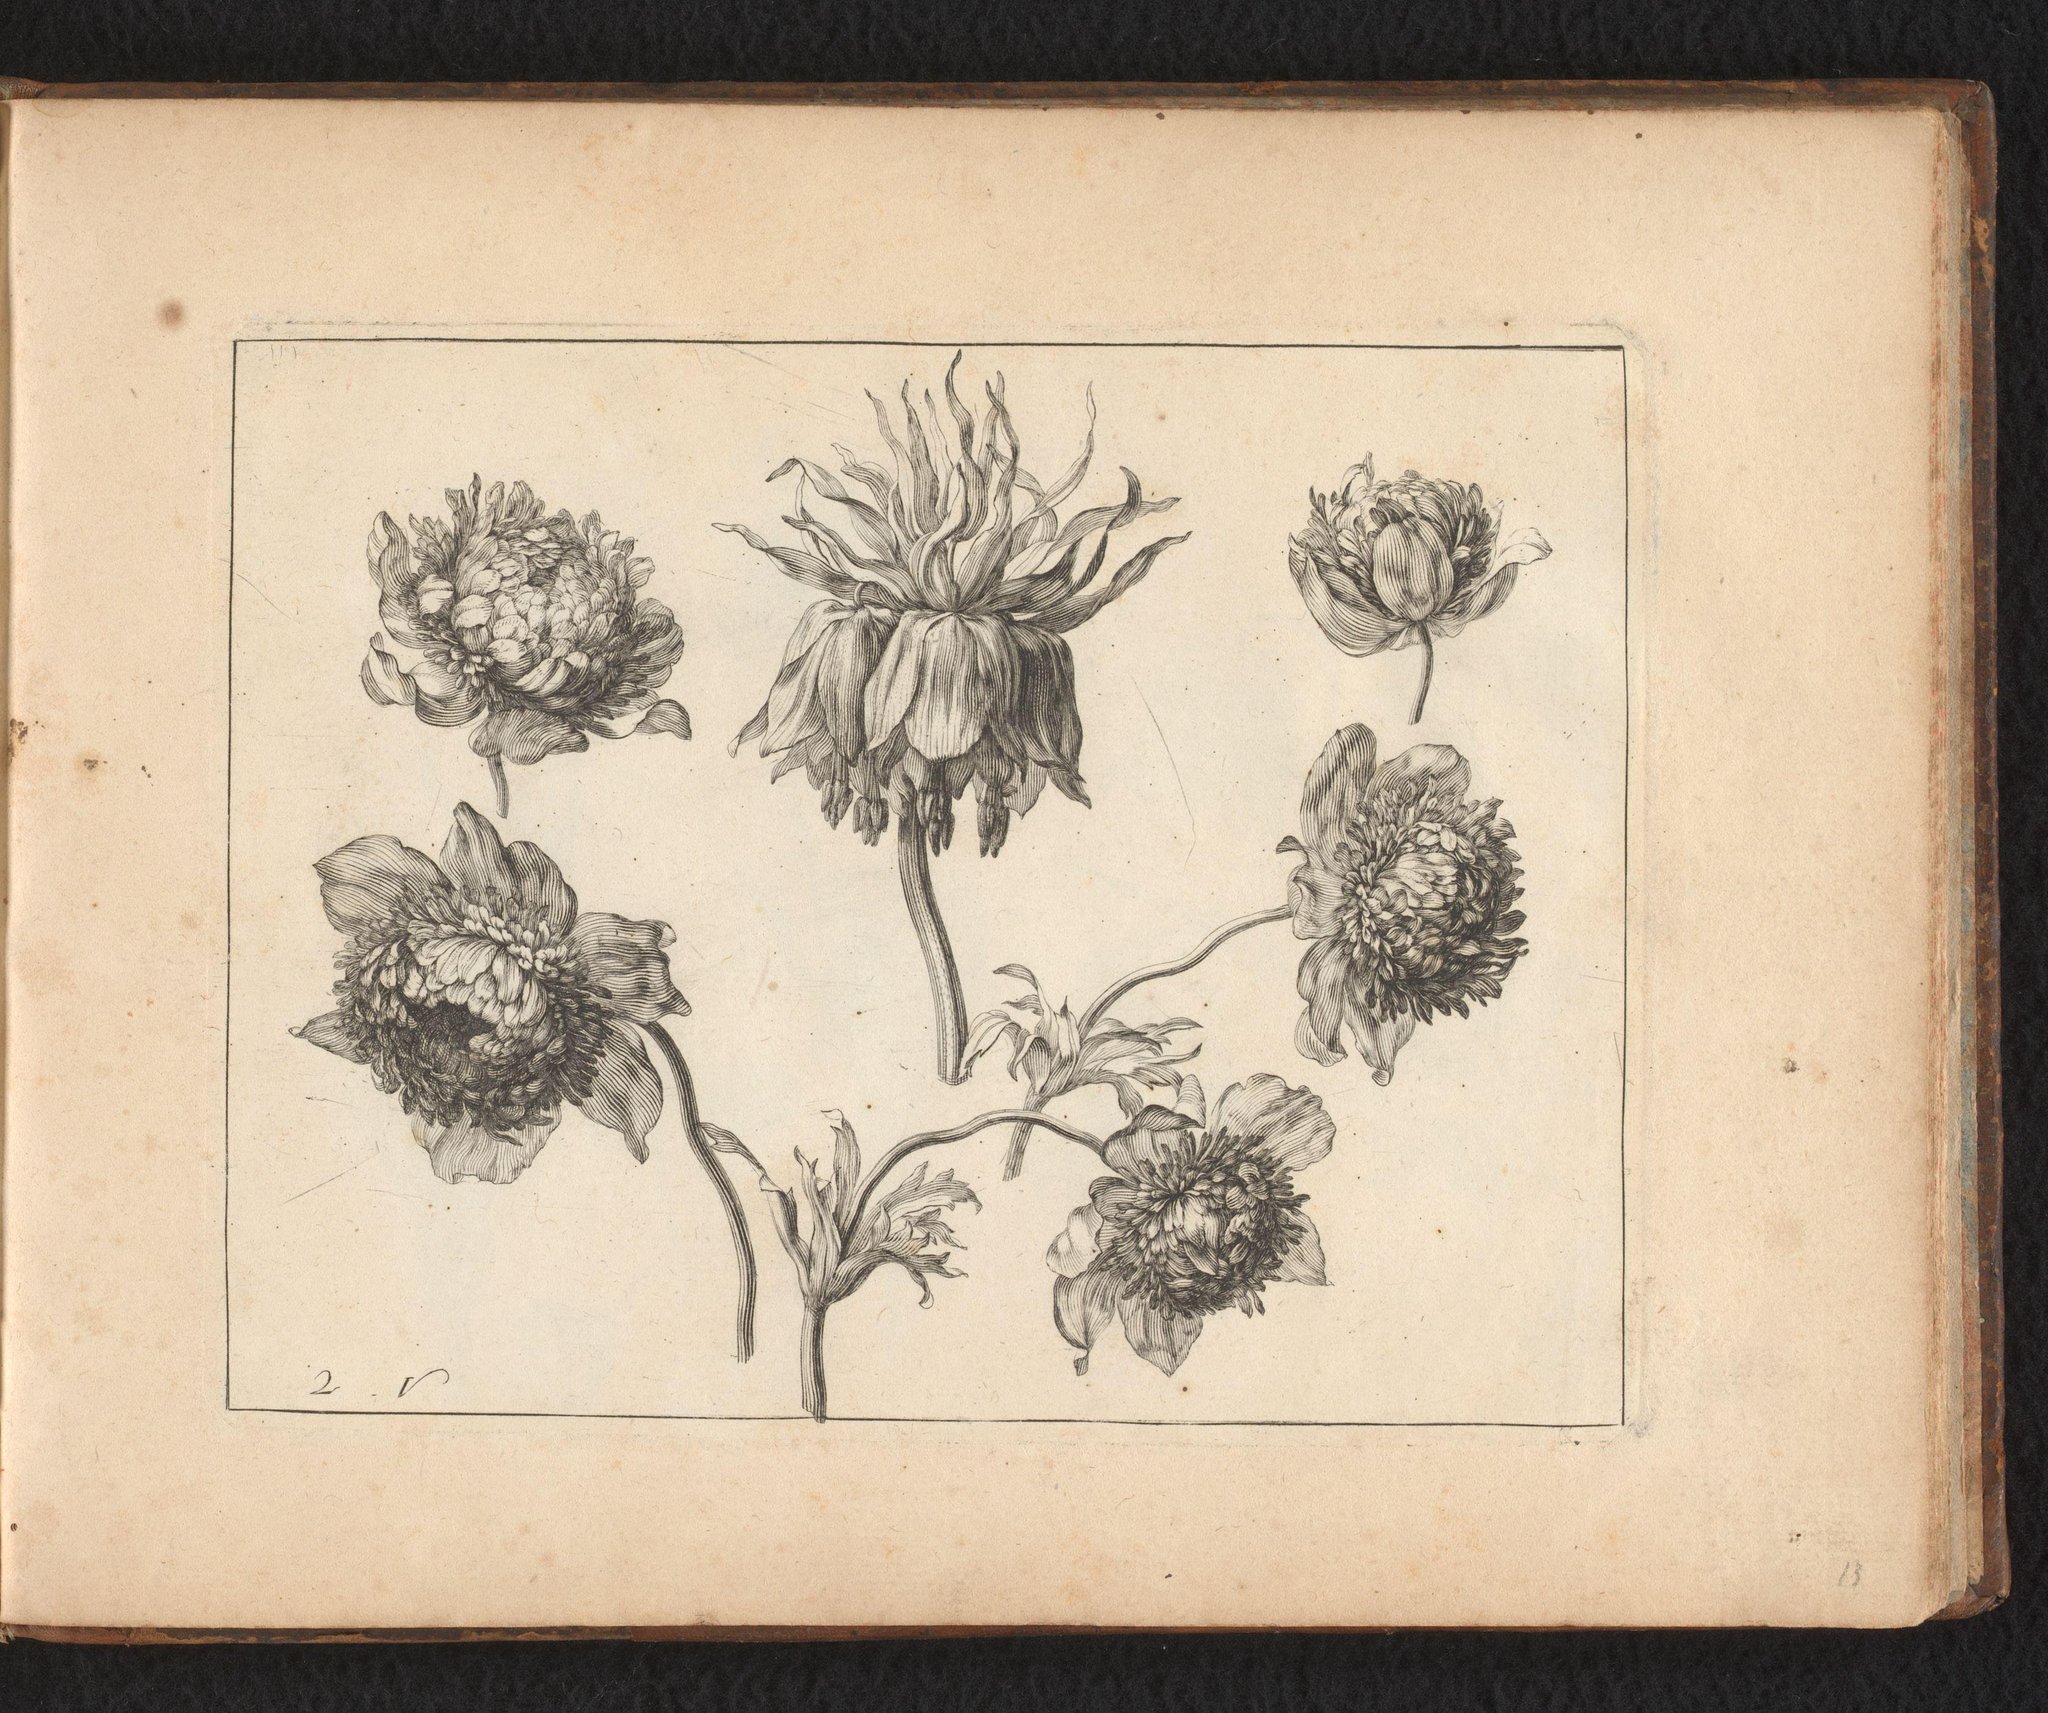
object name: print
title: Verzameling van bloemen, elke soort in verschillende aspecten weergegeven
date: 1650-1676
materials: paper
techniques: engraving, etching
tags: flowers: peony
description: Deze prent maakt deel uit van een album.